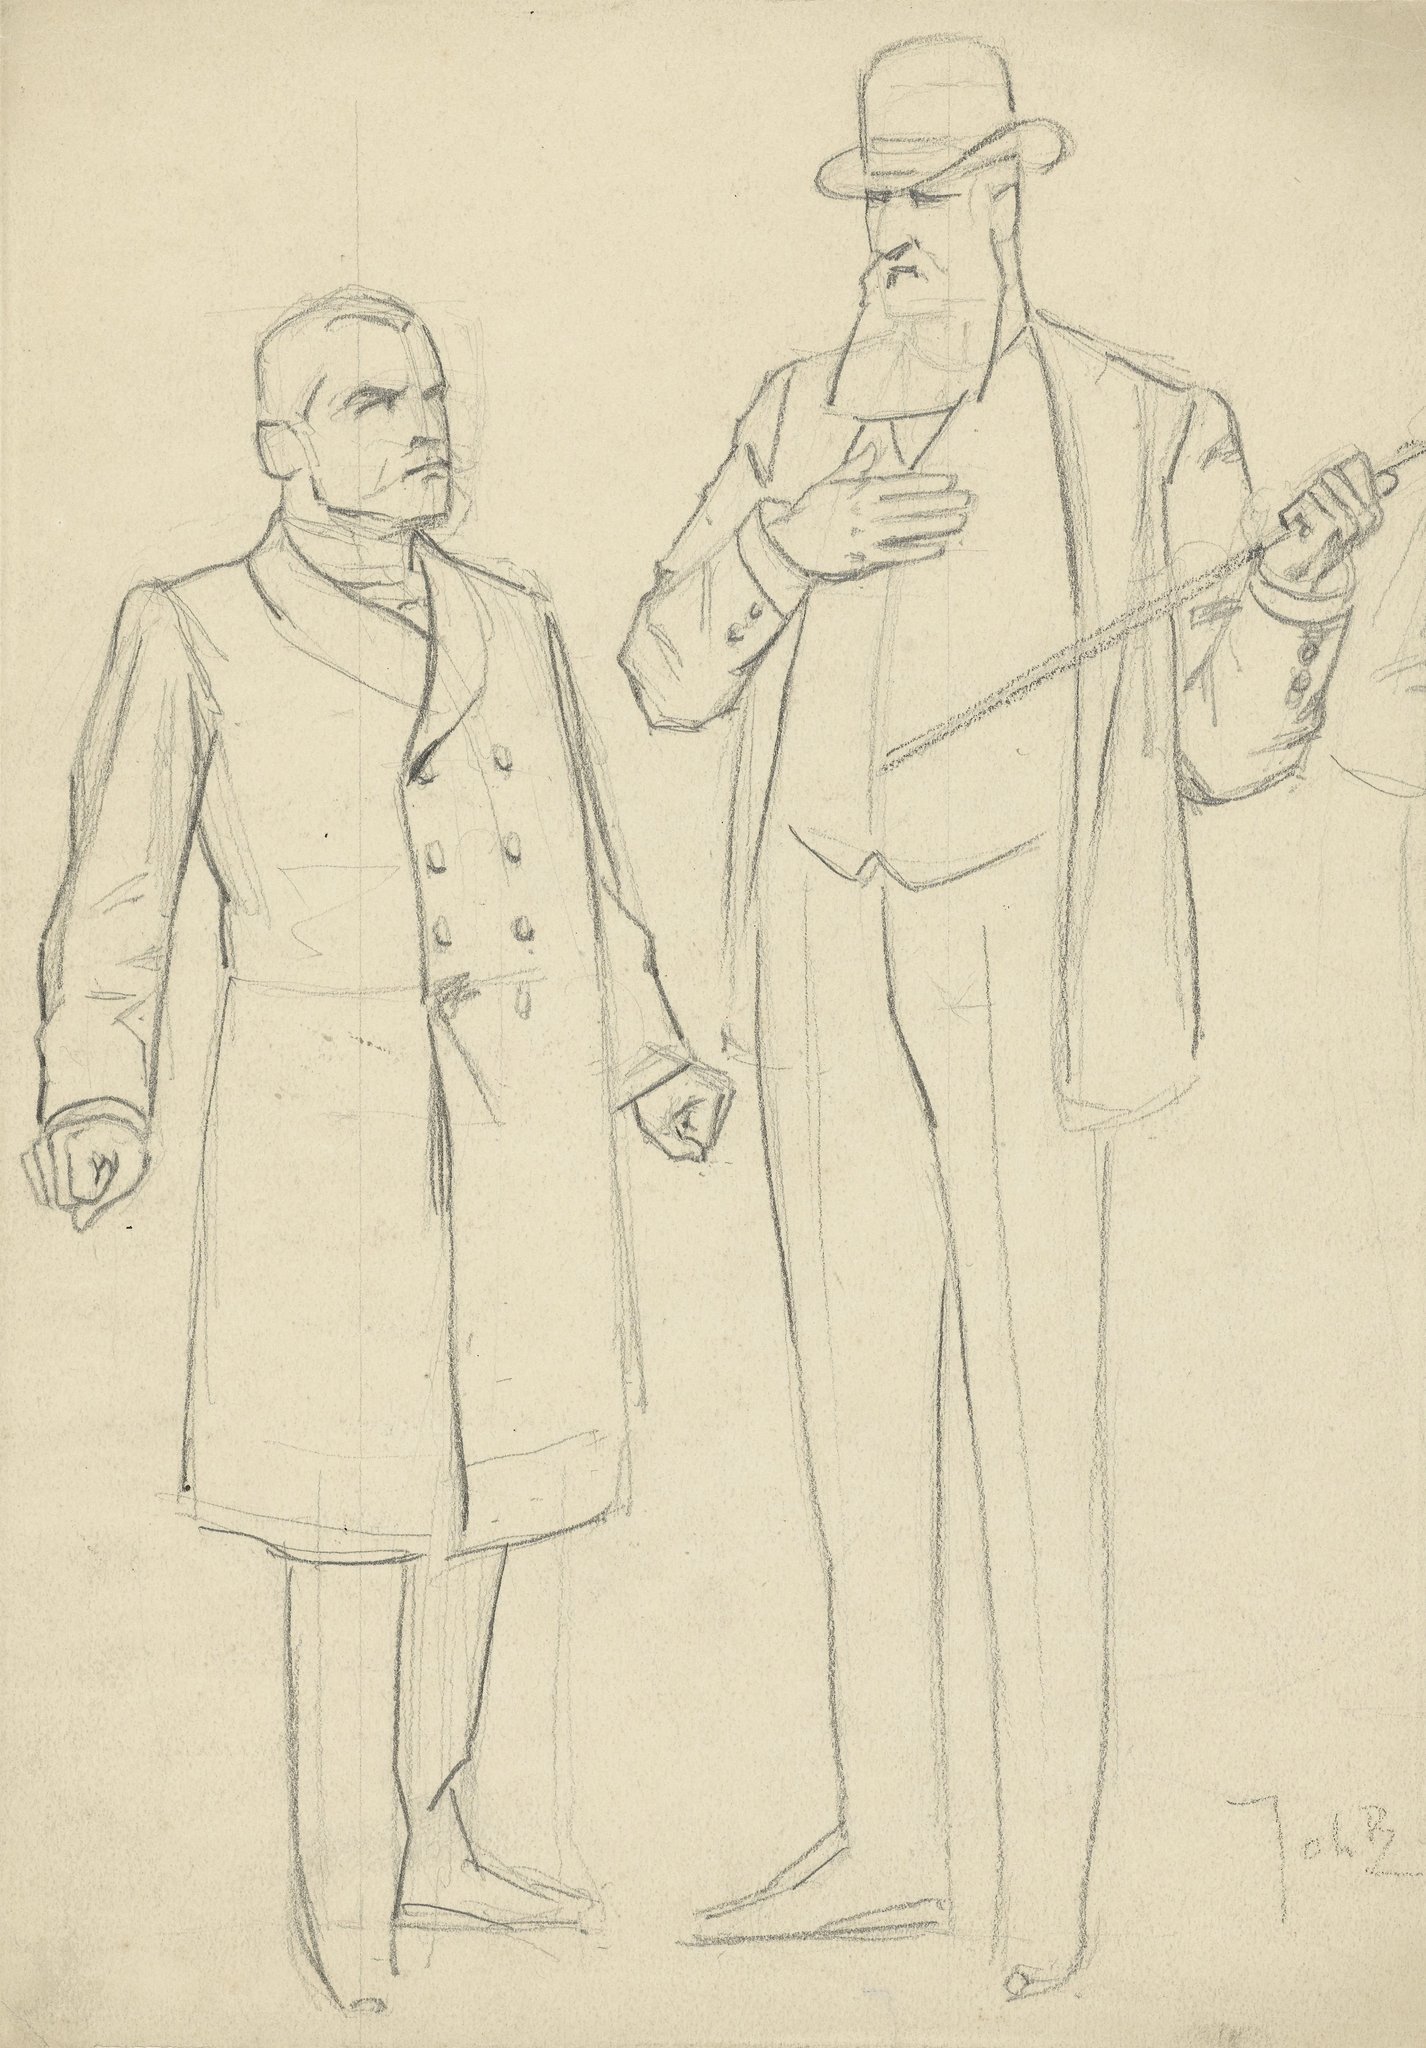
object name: drawing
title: Koning Leopold en Loubet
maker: johan braakensiek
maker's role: draughtsman, print maker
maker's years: 1858-1940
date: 1868-1940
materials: paper, pencil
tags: brussels, laeken, leopold ii (koning der belgen), historical persons, historical events and situations, political caricatures and satires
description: Ontwerp voor spotprent 'Koning Leopold in Parijs om zich te verdedigen als Congo-Koning', 1903. Ontwerp voor een prent.